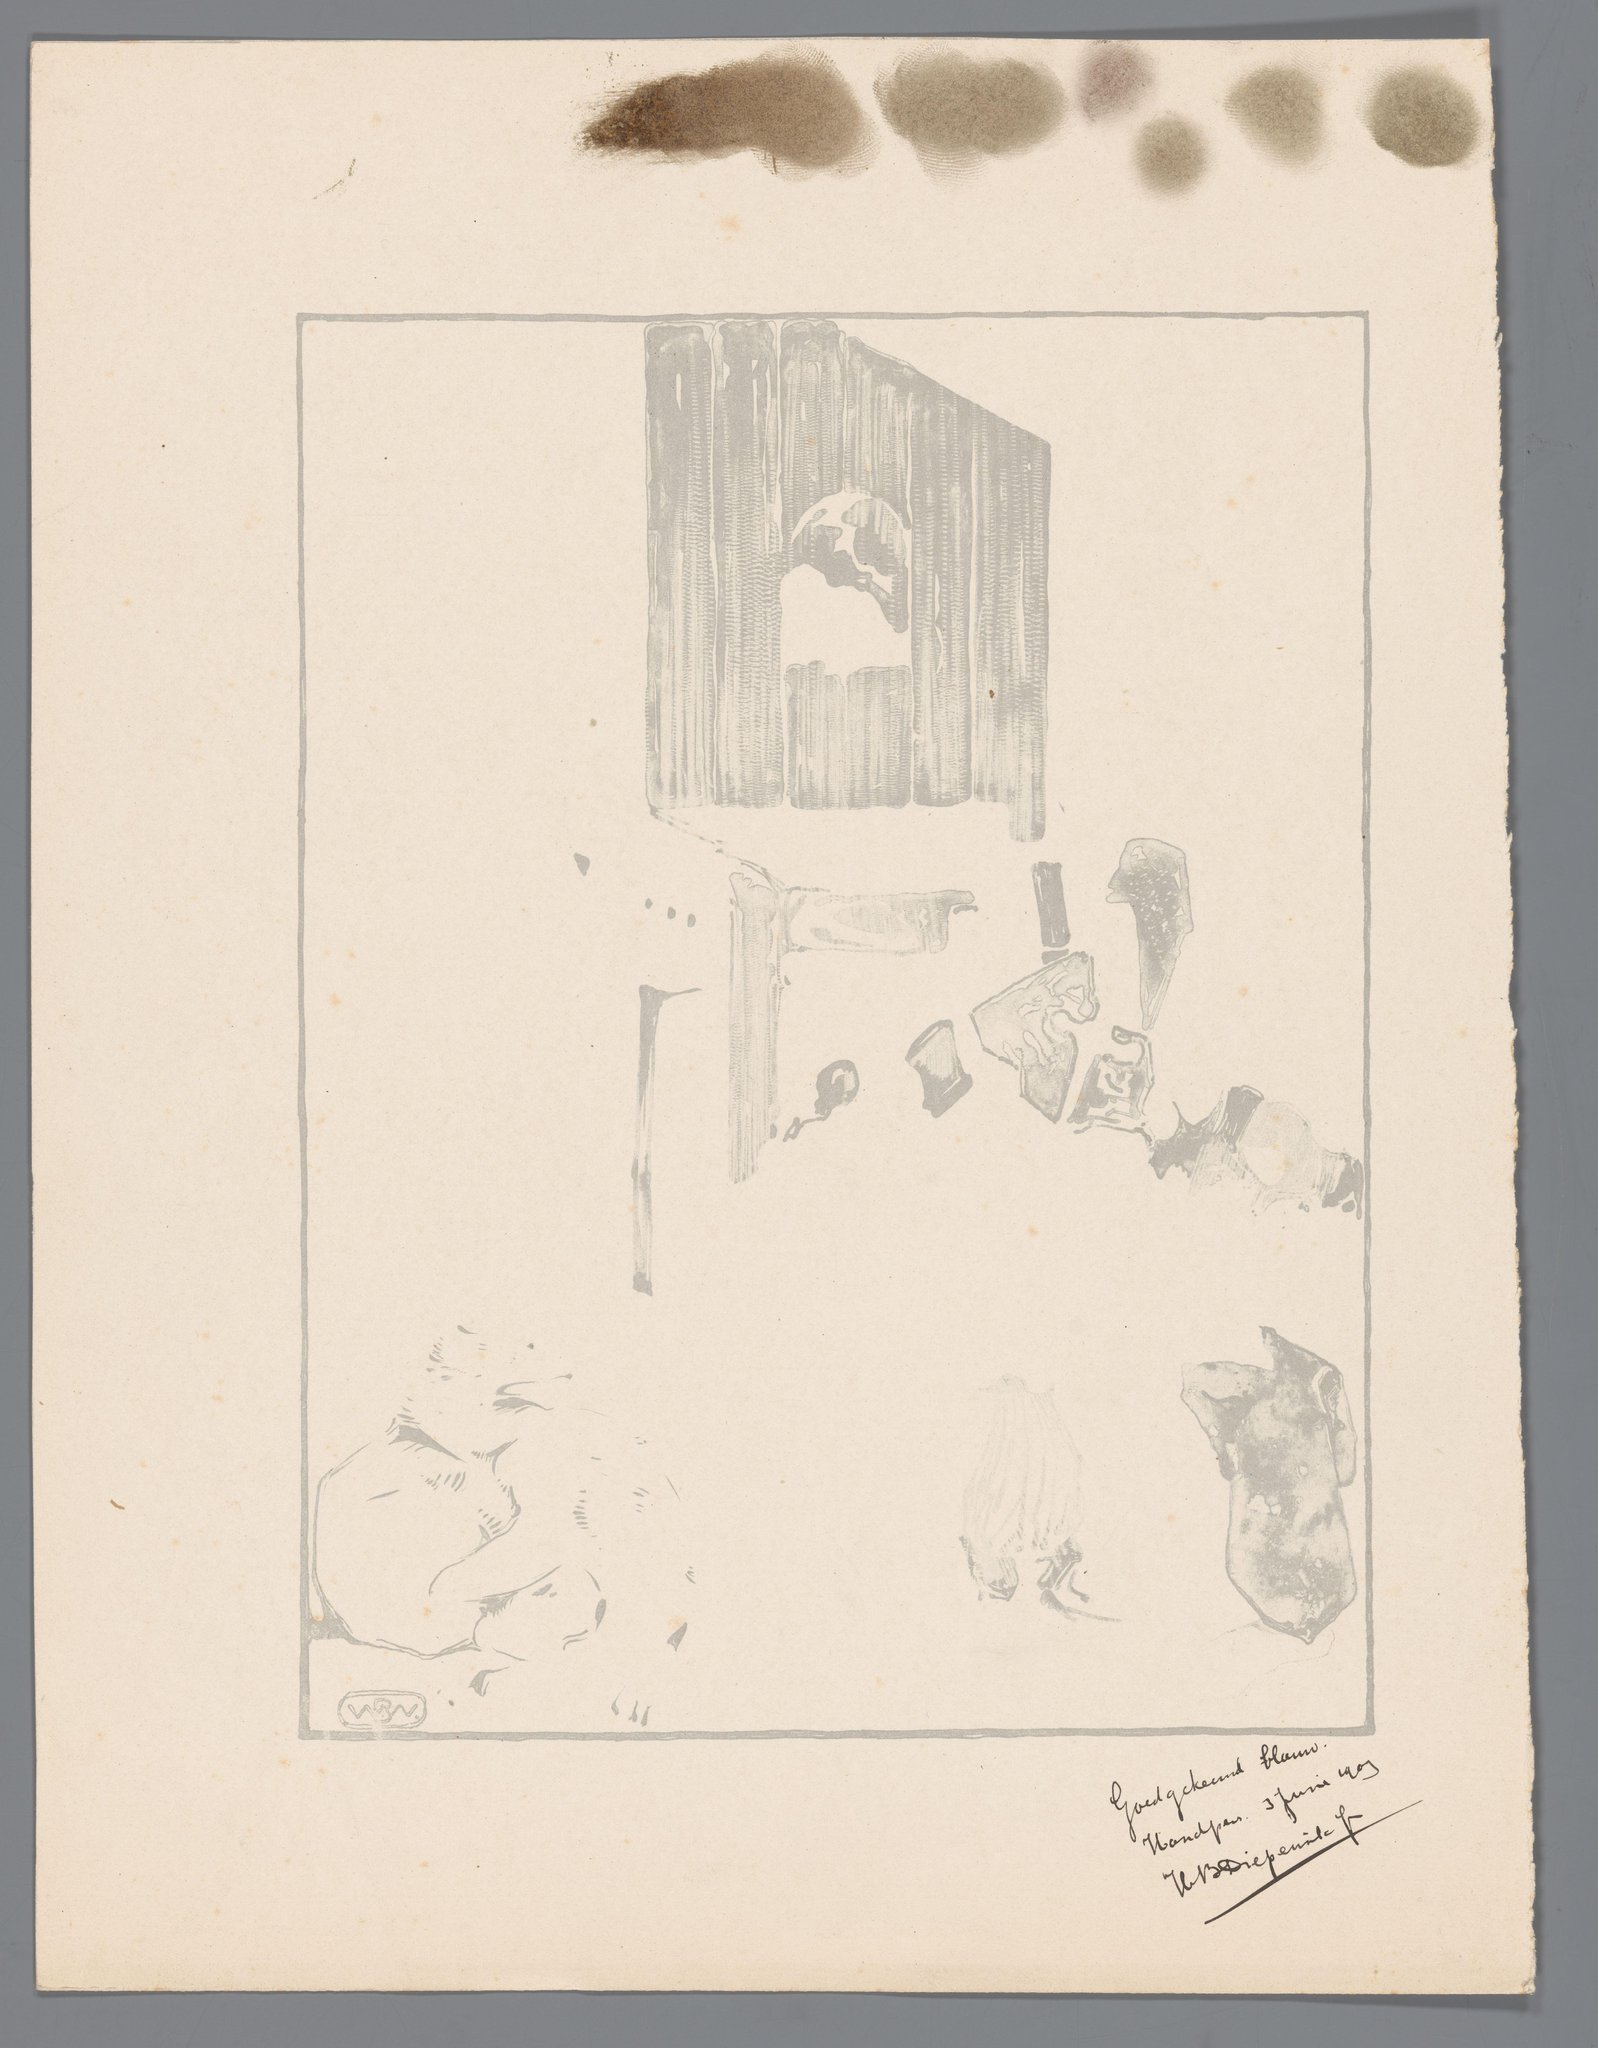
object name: print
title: Beer (Bruun) wordt aangevallen door een menigte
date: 1909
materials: paper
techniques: lithograph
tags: fable of reynard the fox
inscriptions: collector's mark: Lugt 2228, inscription: ‘Goedgekeurd blauw./ Handpers. 3 juni 1909/ HB Dieperink Jr’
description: Ontwerp voor: Streuvels, Stijn (Frank Lateur). Reinaert de Vos naar verschillende uitgaven van het middeleeuwsche epos. Amsterdam: L.J. Veen, 1910.